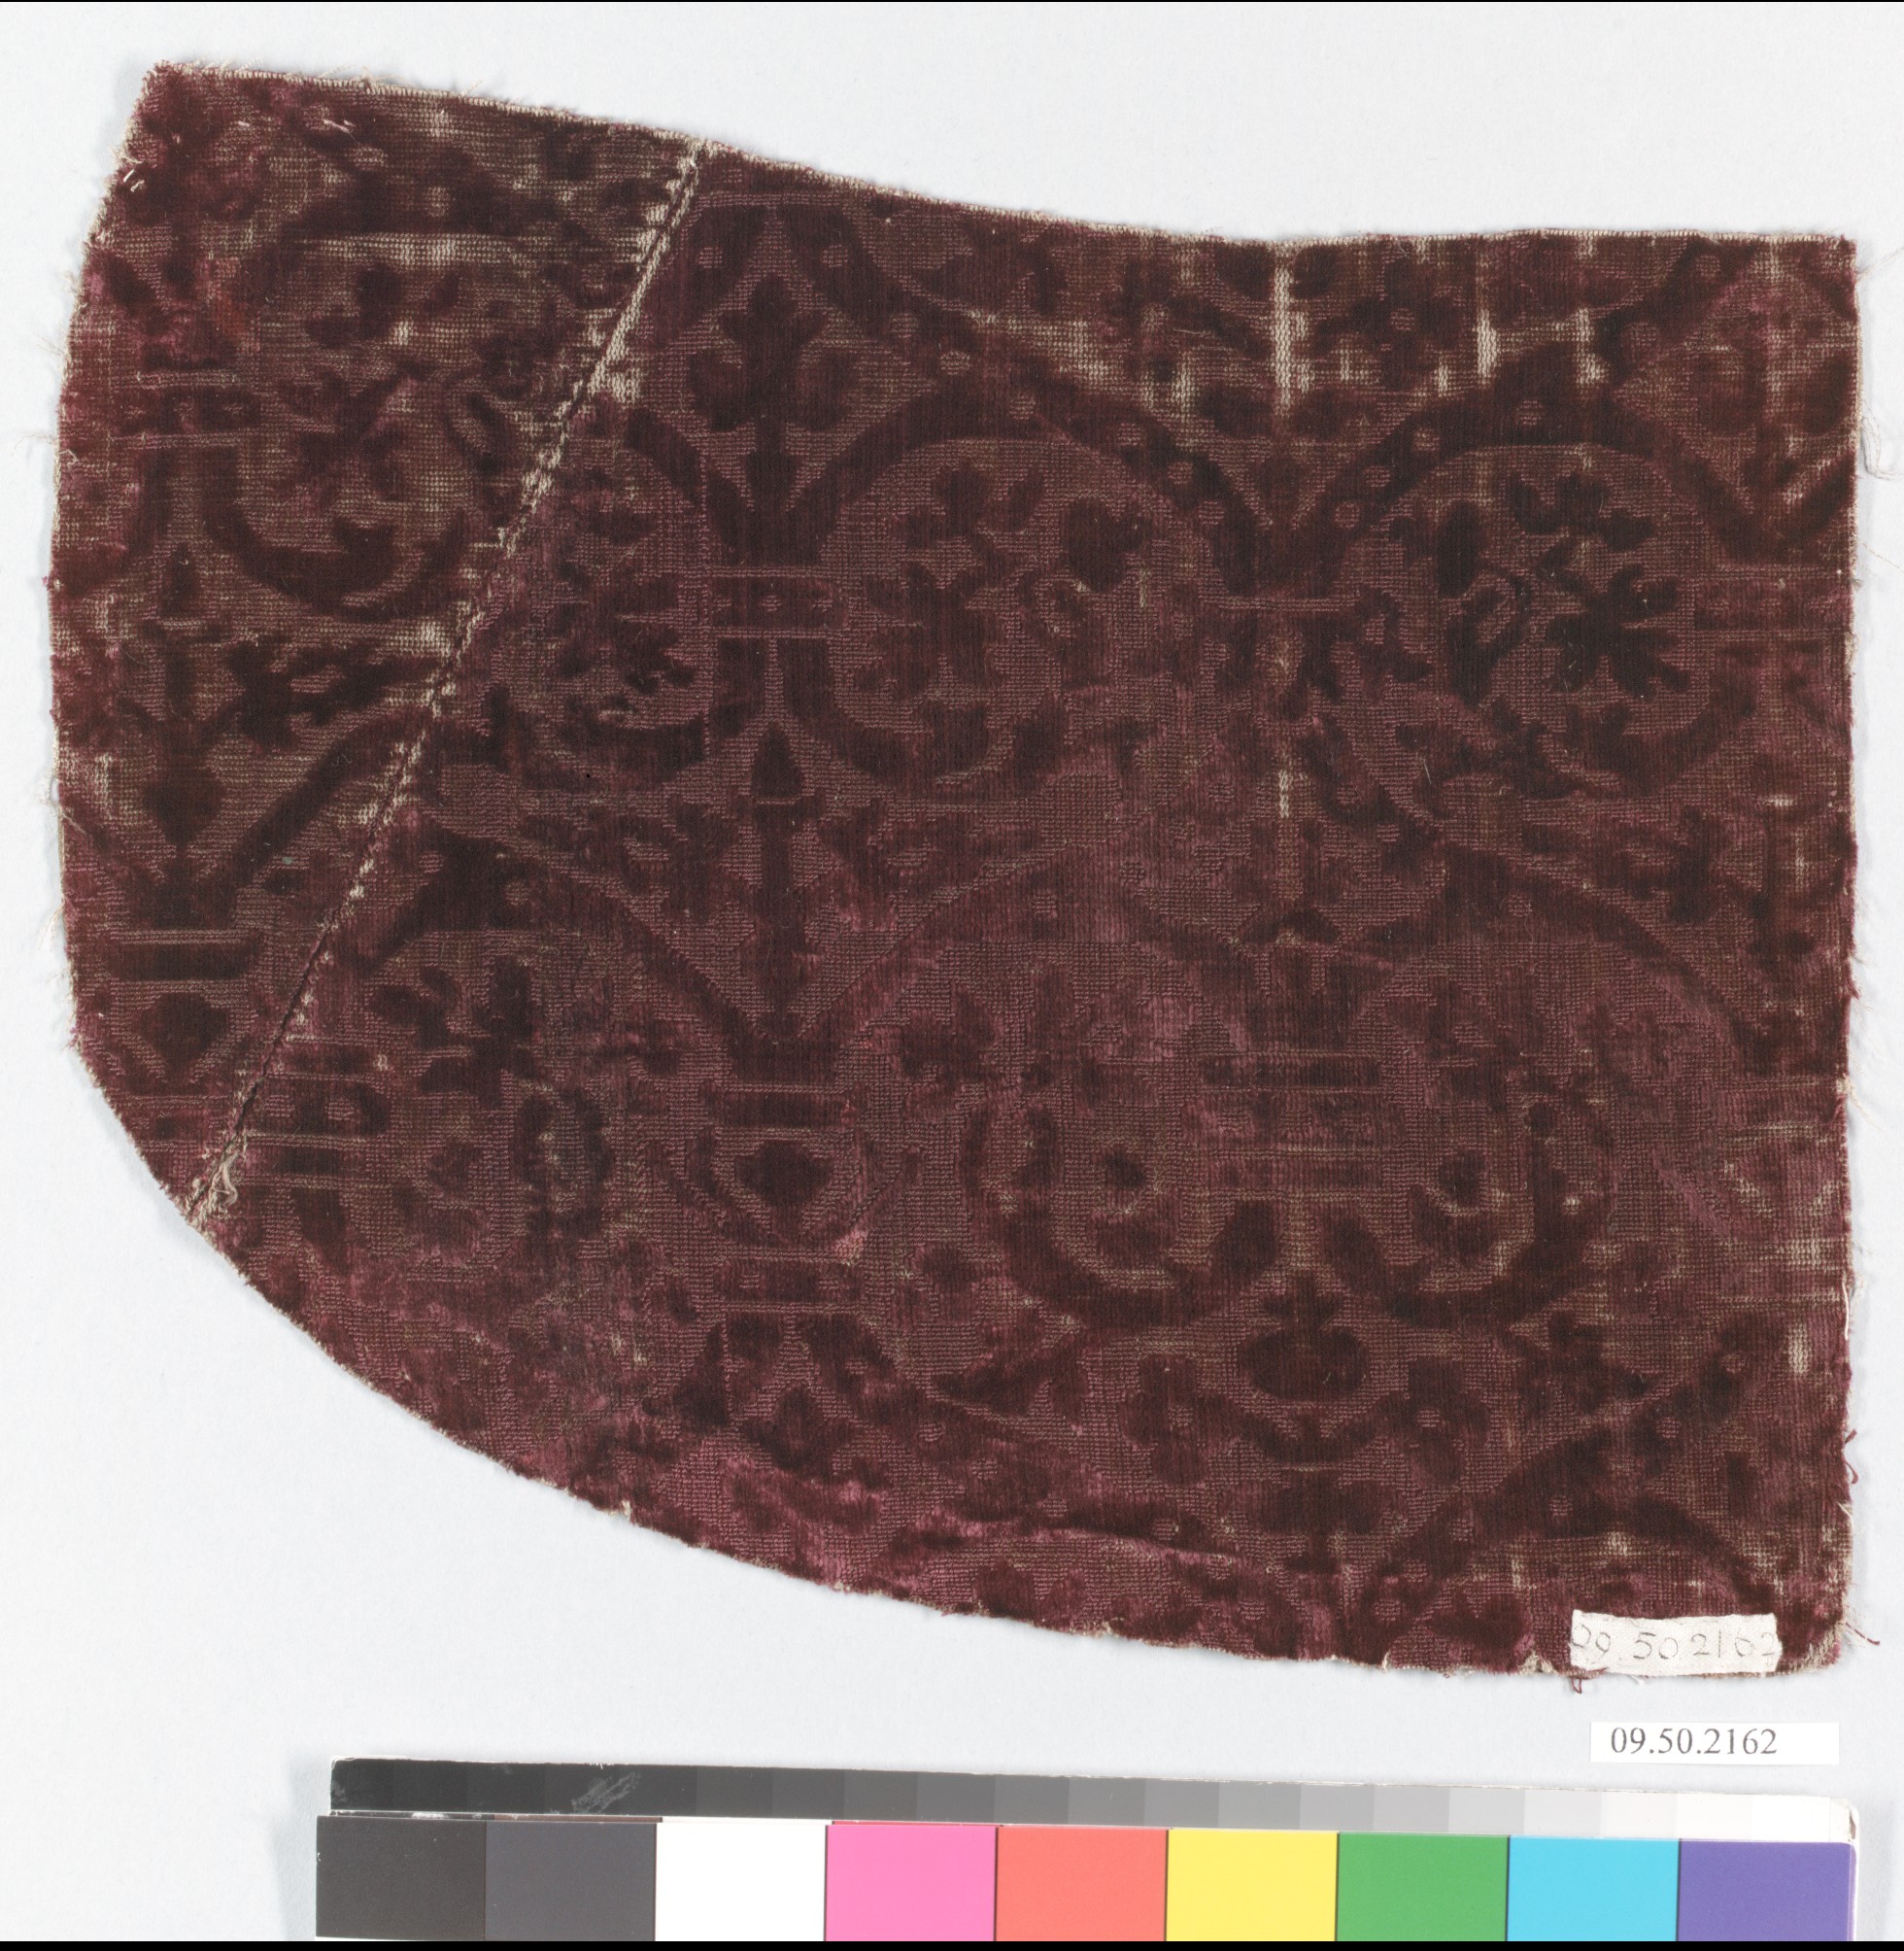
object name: piece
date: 1501-1700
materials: silk